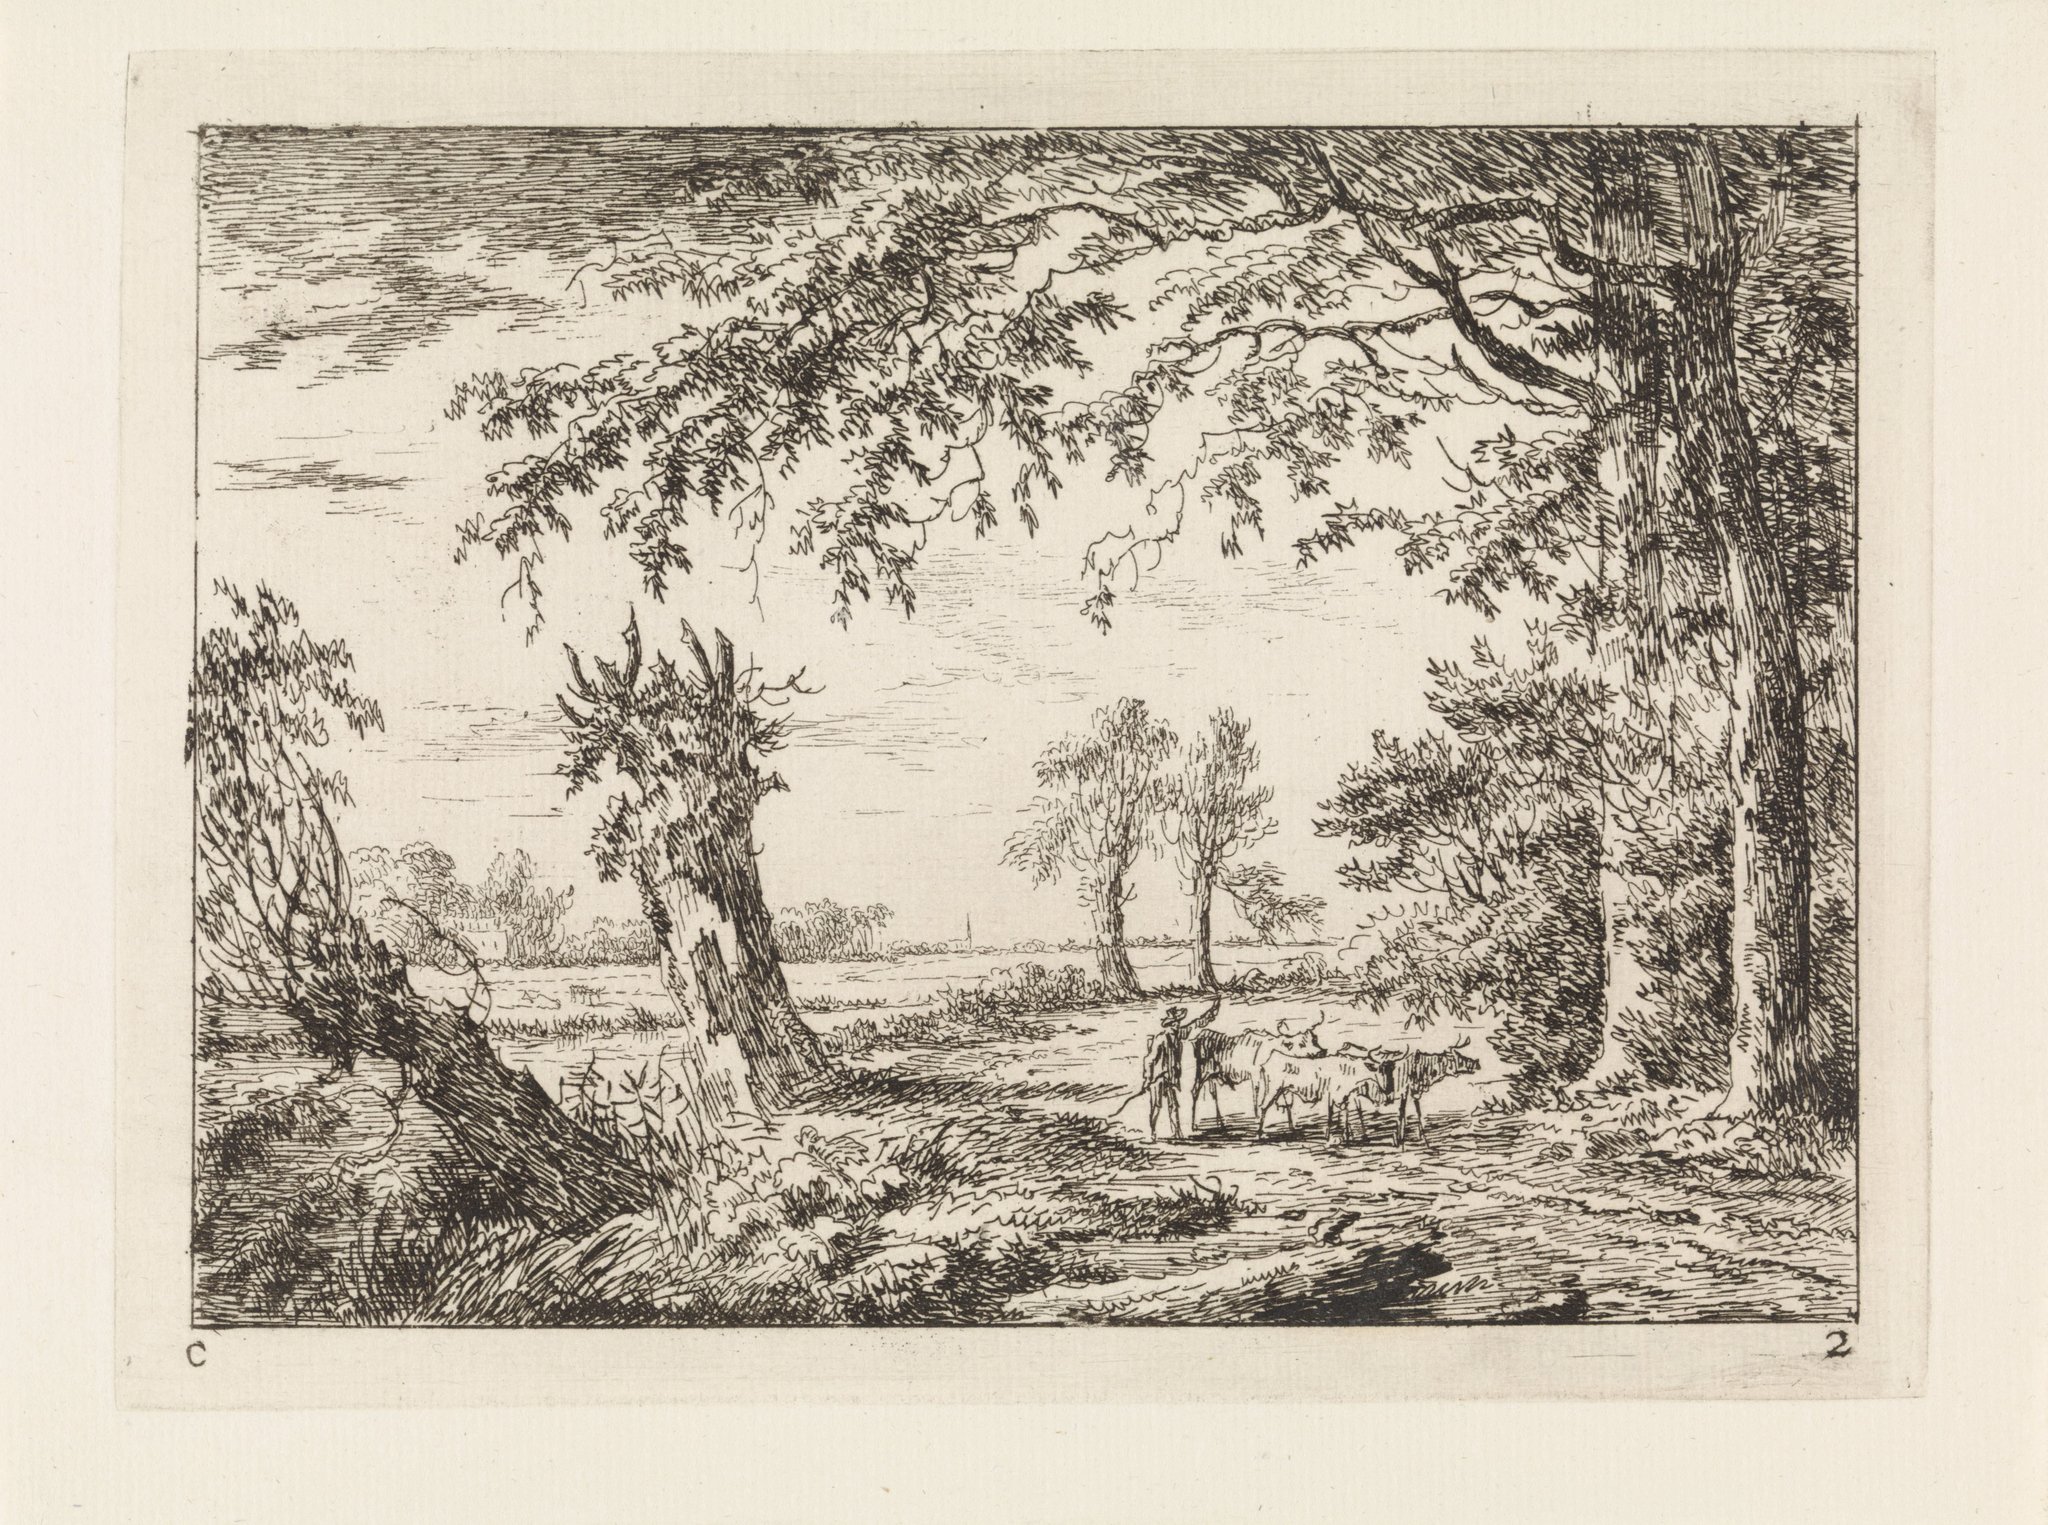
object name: print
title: Boer met koeien op een weg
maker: gerard van nijmegen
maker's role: draughtsman, painter, print maker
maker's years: 1735-1808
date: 1794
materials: paper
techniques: etching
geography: rotterdam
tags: trees, cow, cattle driving, cattle driver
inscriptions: collector's mark: Lugt 2228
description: Op een weg, met aan weerszijden bomen, drijft een boer drie koeien. Aan de linkerkant is een sloot. Linksonder: c.